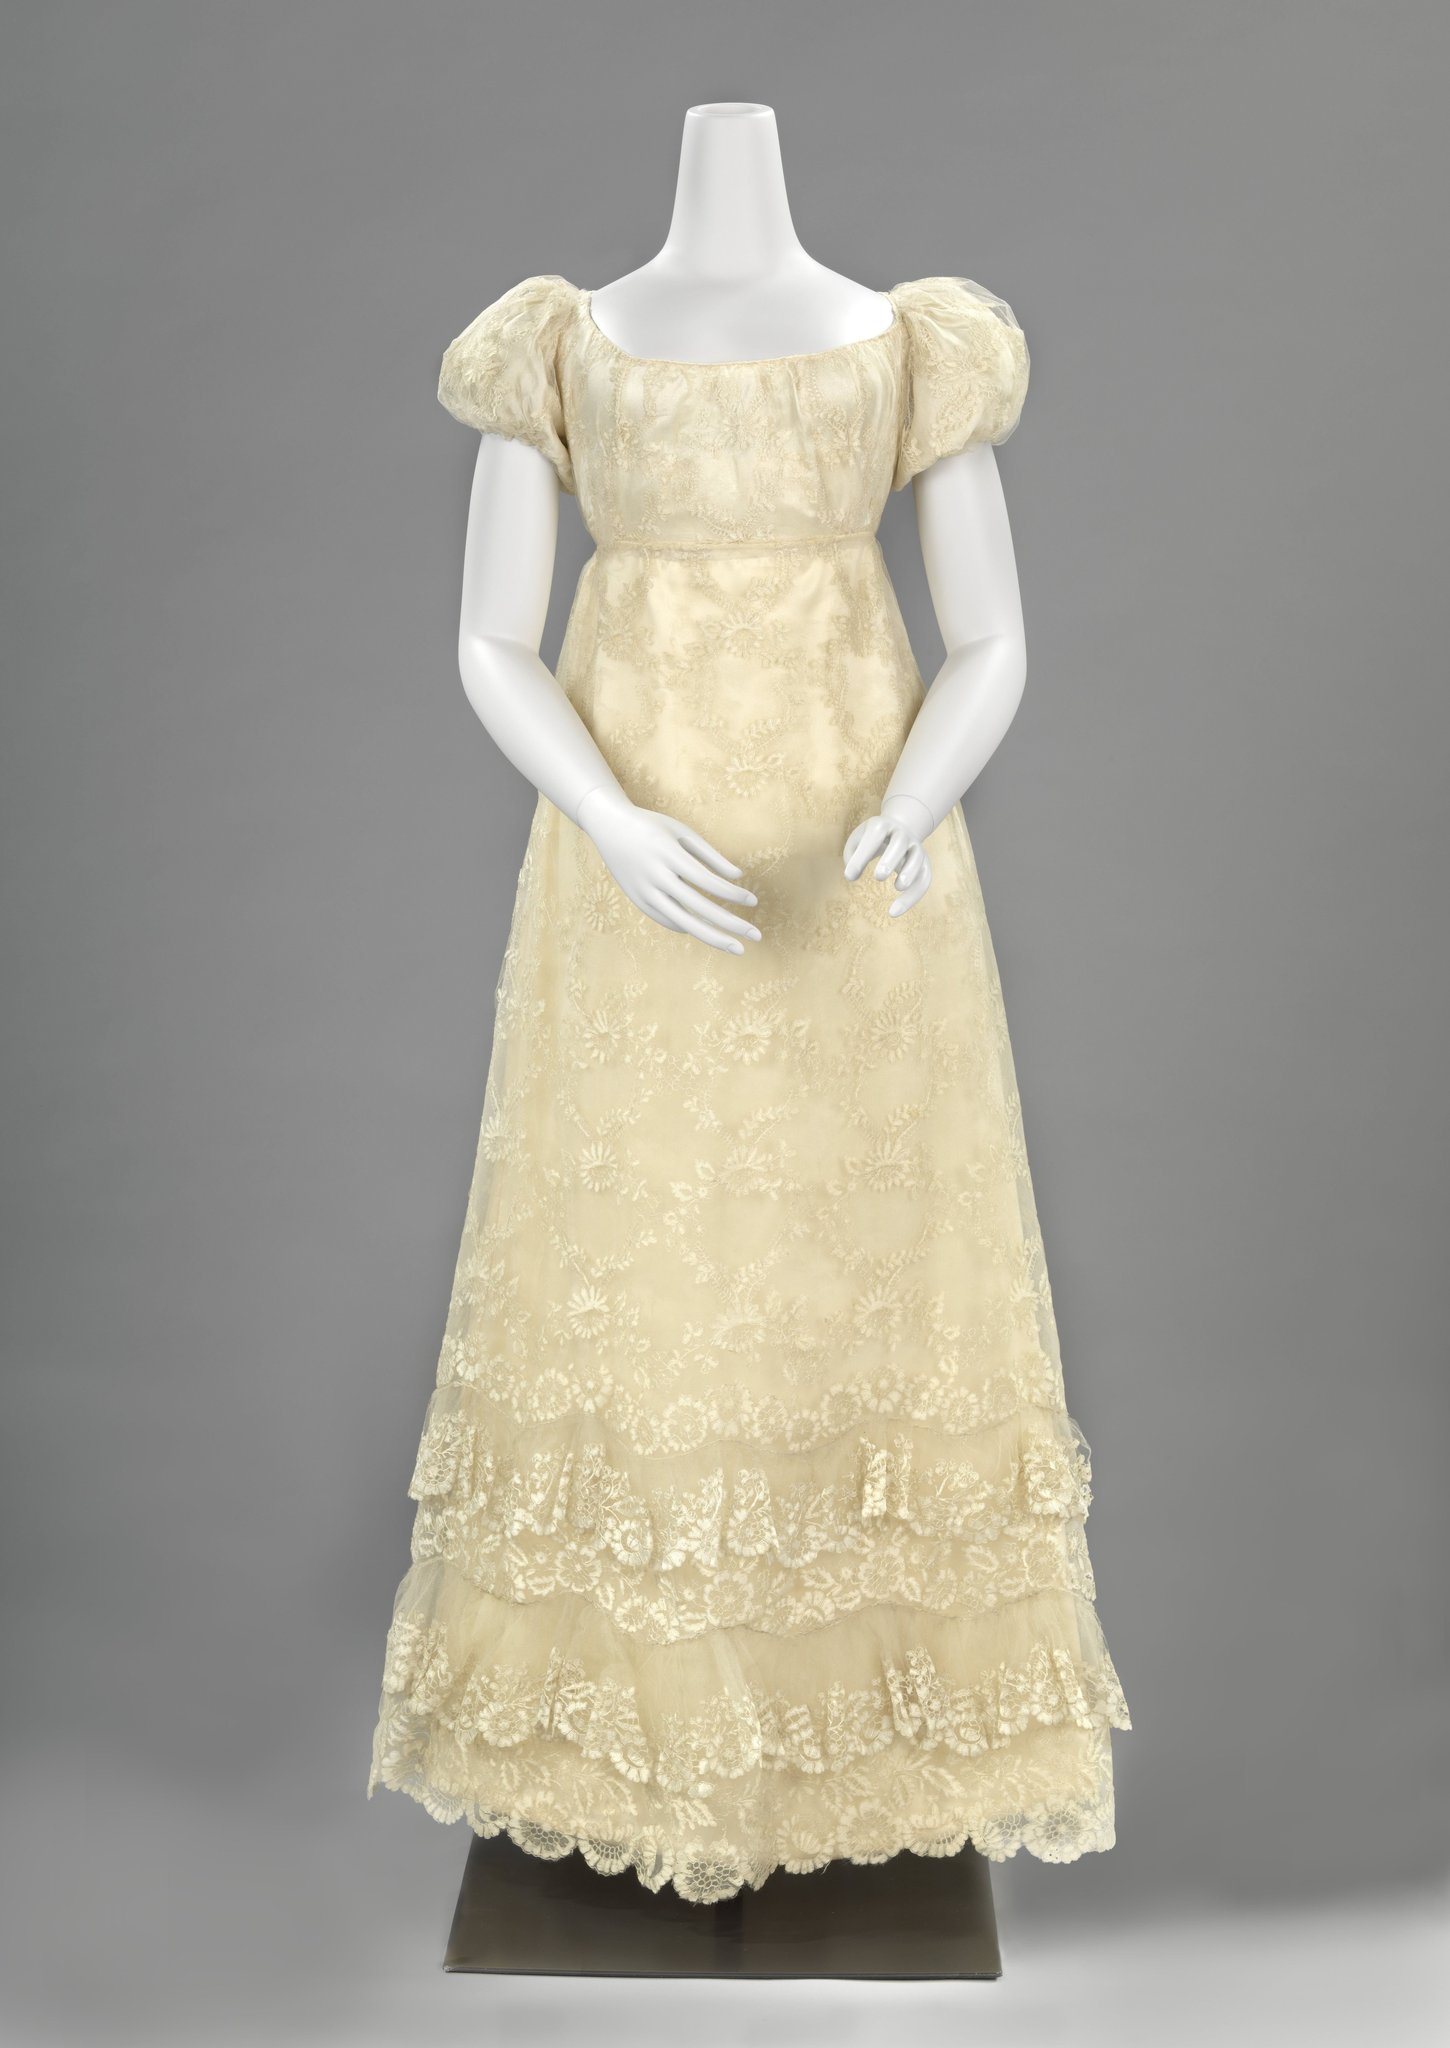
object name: womenswear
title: Ball Dress of Blonde Lace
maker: Anonymous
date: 1815-1820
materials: silk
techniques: lace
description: Lace had been out of fashion since the French revolution. However, it regained its popularity when Napoleon decreed it should be worn at court in 1804. This dress is made of hand-made silk bobbin lace known as ‘blonde’. The name is derived from the often light colour of the silk from which it was often made. The material is very fragile, and dresses made of it are exceedingly rare.